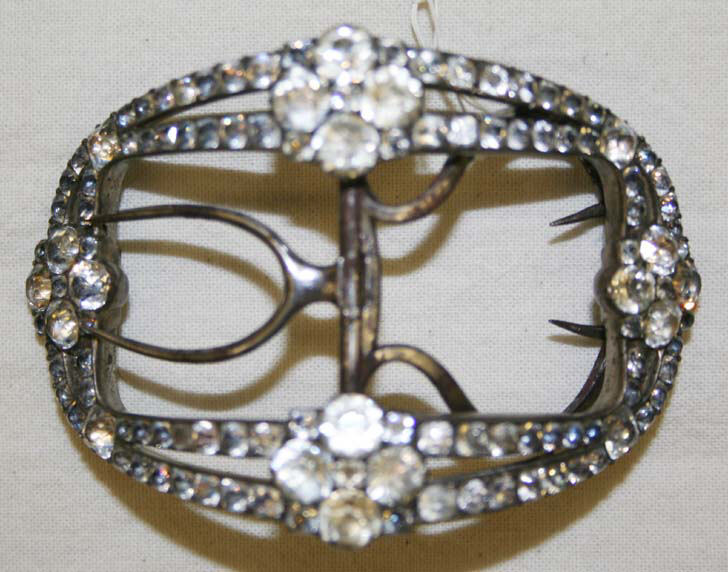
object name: shoe buckle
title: Shoe buckles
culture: french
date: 1767-1800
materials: metal